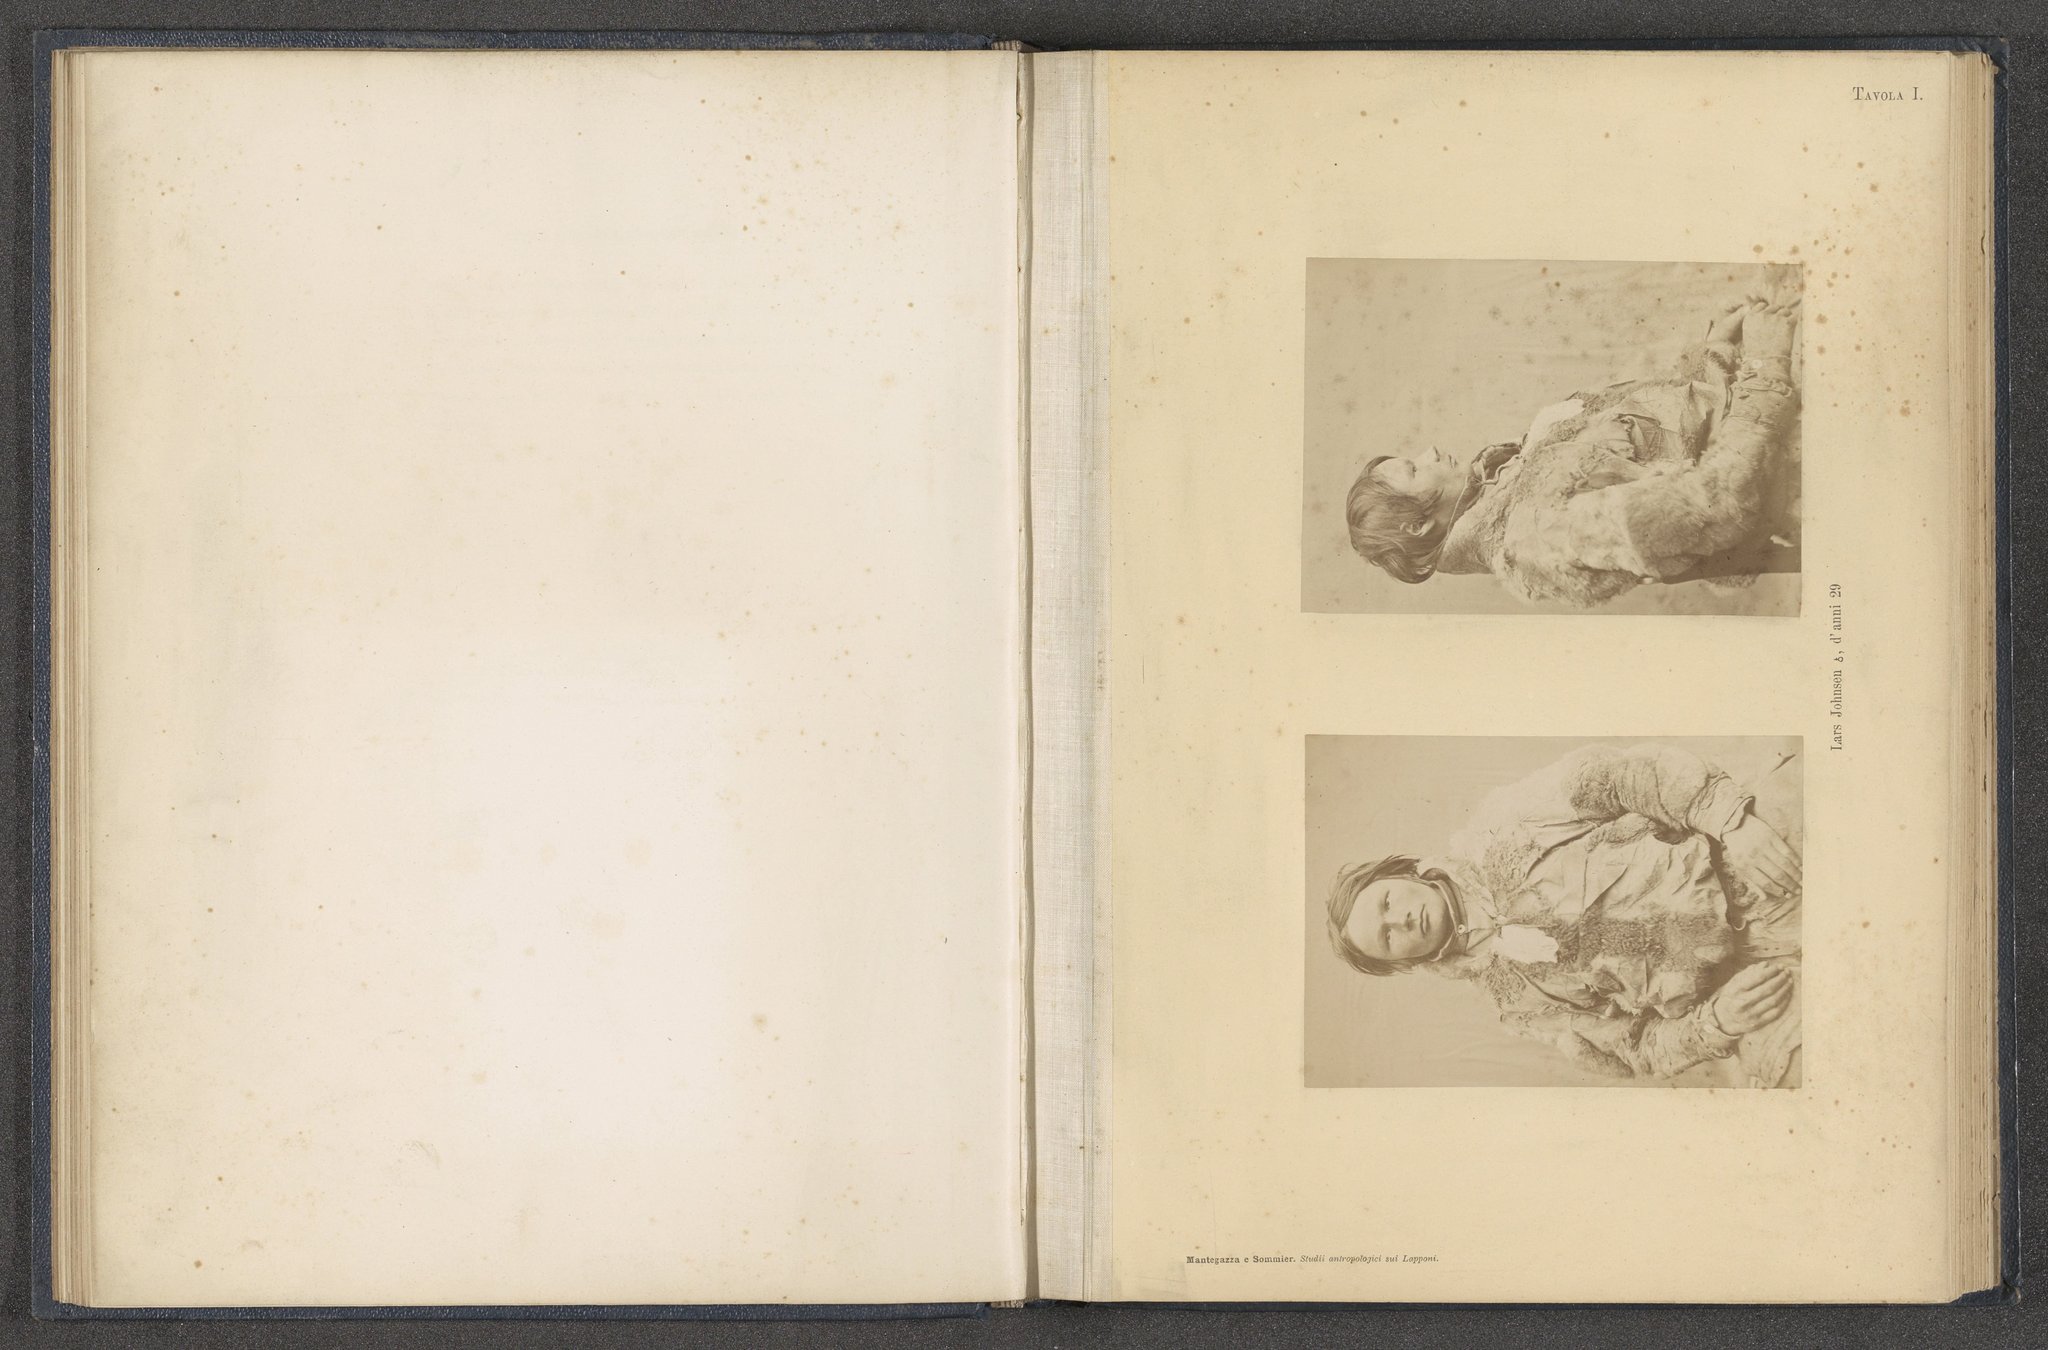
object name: page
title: Lars Johnsen ♂, d' anni 29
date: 1870-1880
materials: paper, photographic support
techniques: albumen print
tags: adult man (+ front view), adult man (+ sideview, profile), fashion, clothing (+ fur used for clothes)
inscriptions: number: ‘Tavola I.’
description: Links een vooraanzicht, rechts een zijaanzicht.